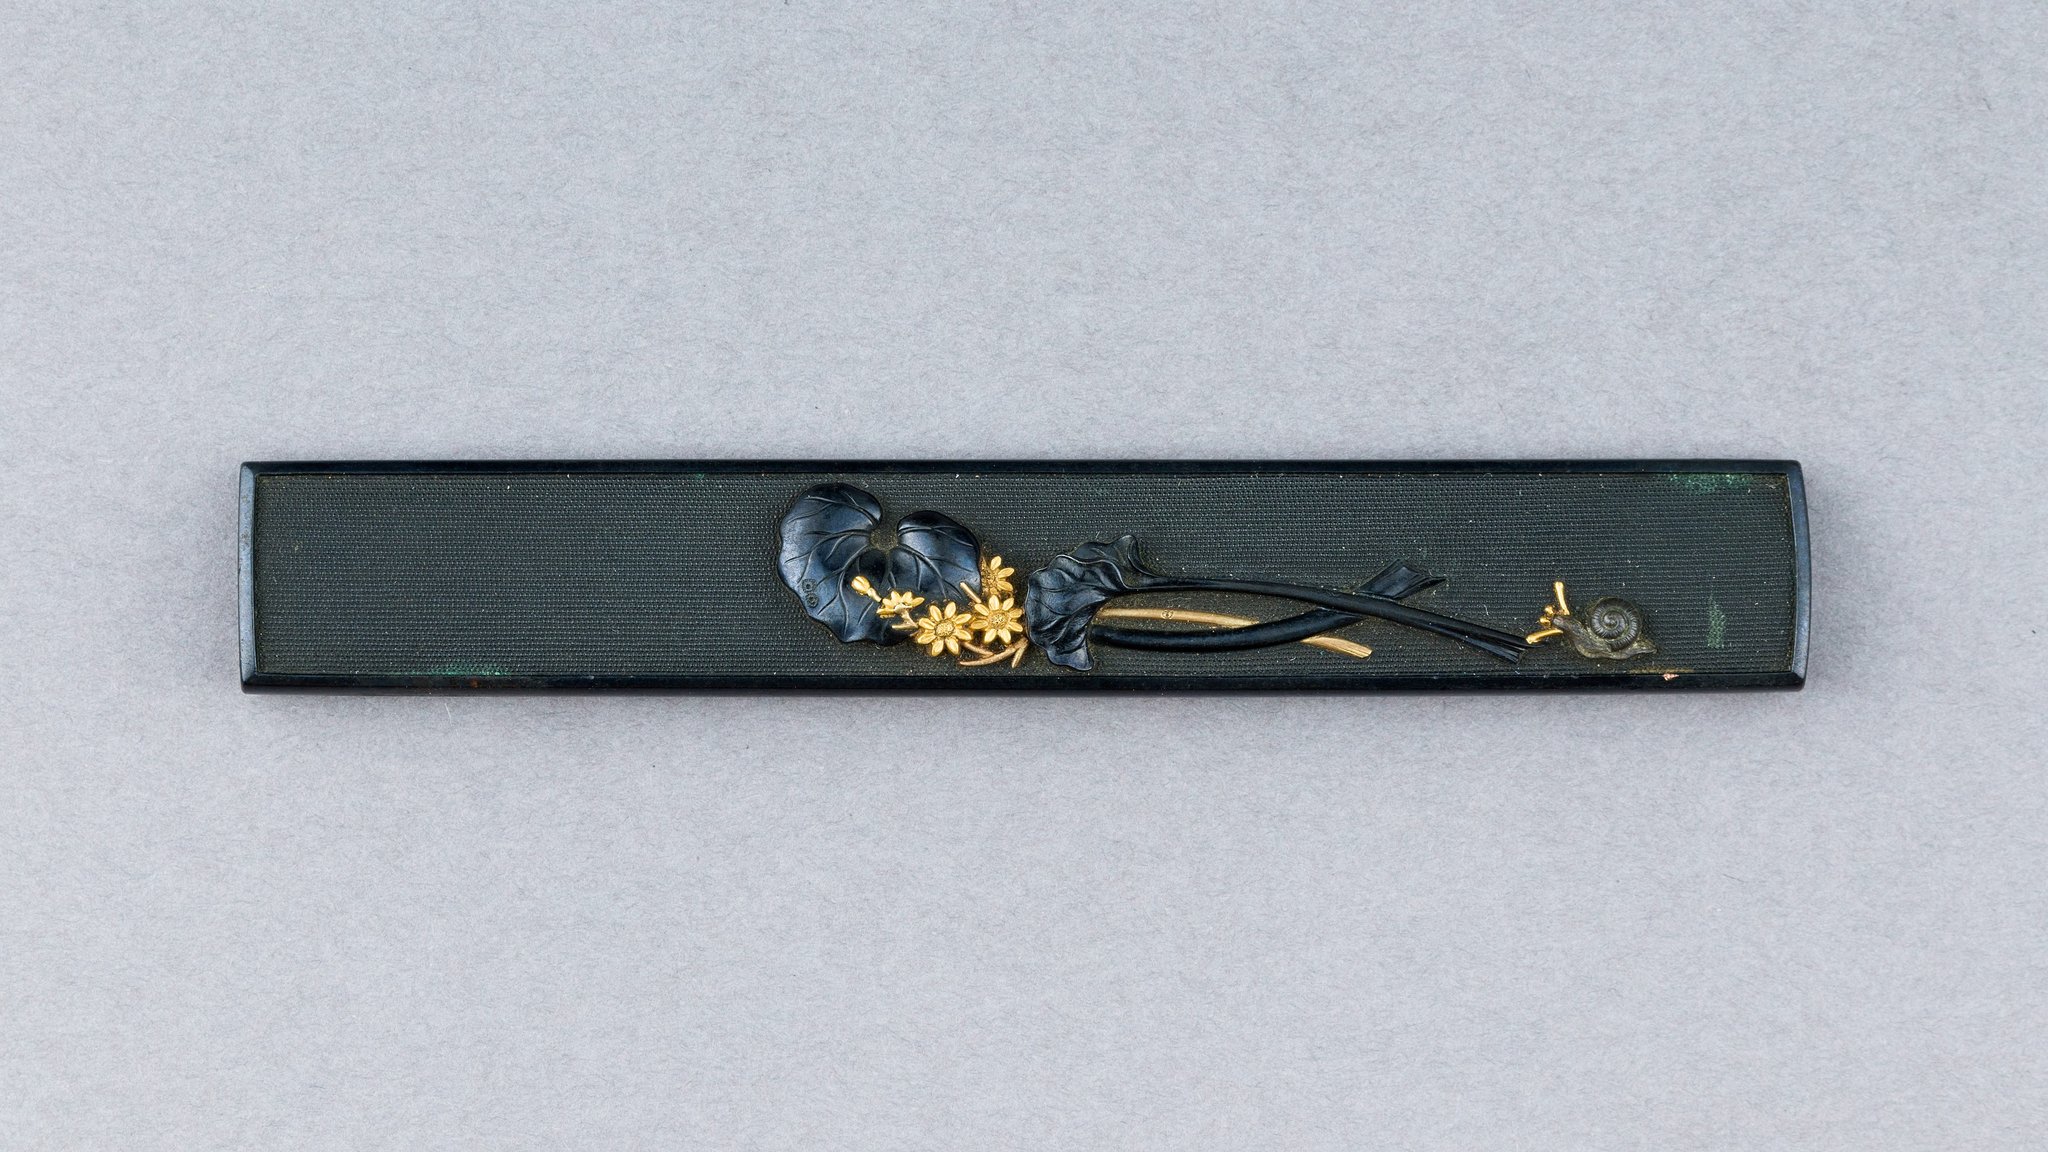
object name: knife handle kozuka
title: Knife Handle (Kozuka)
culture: japanese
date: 1615-1868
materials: gold alloy, gold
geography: japan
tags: snails,flowers